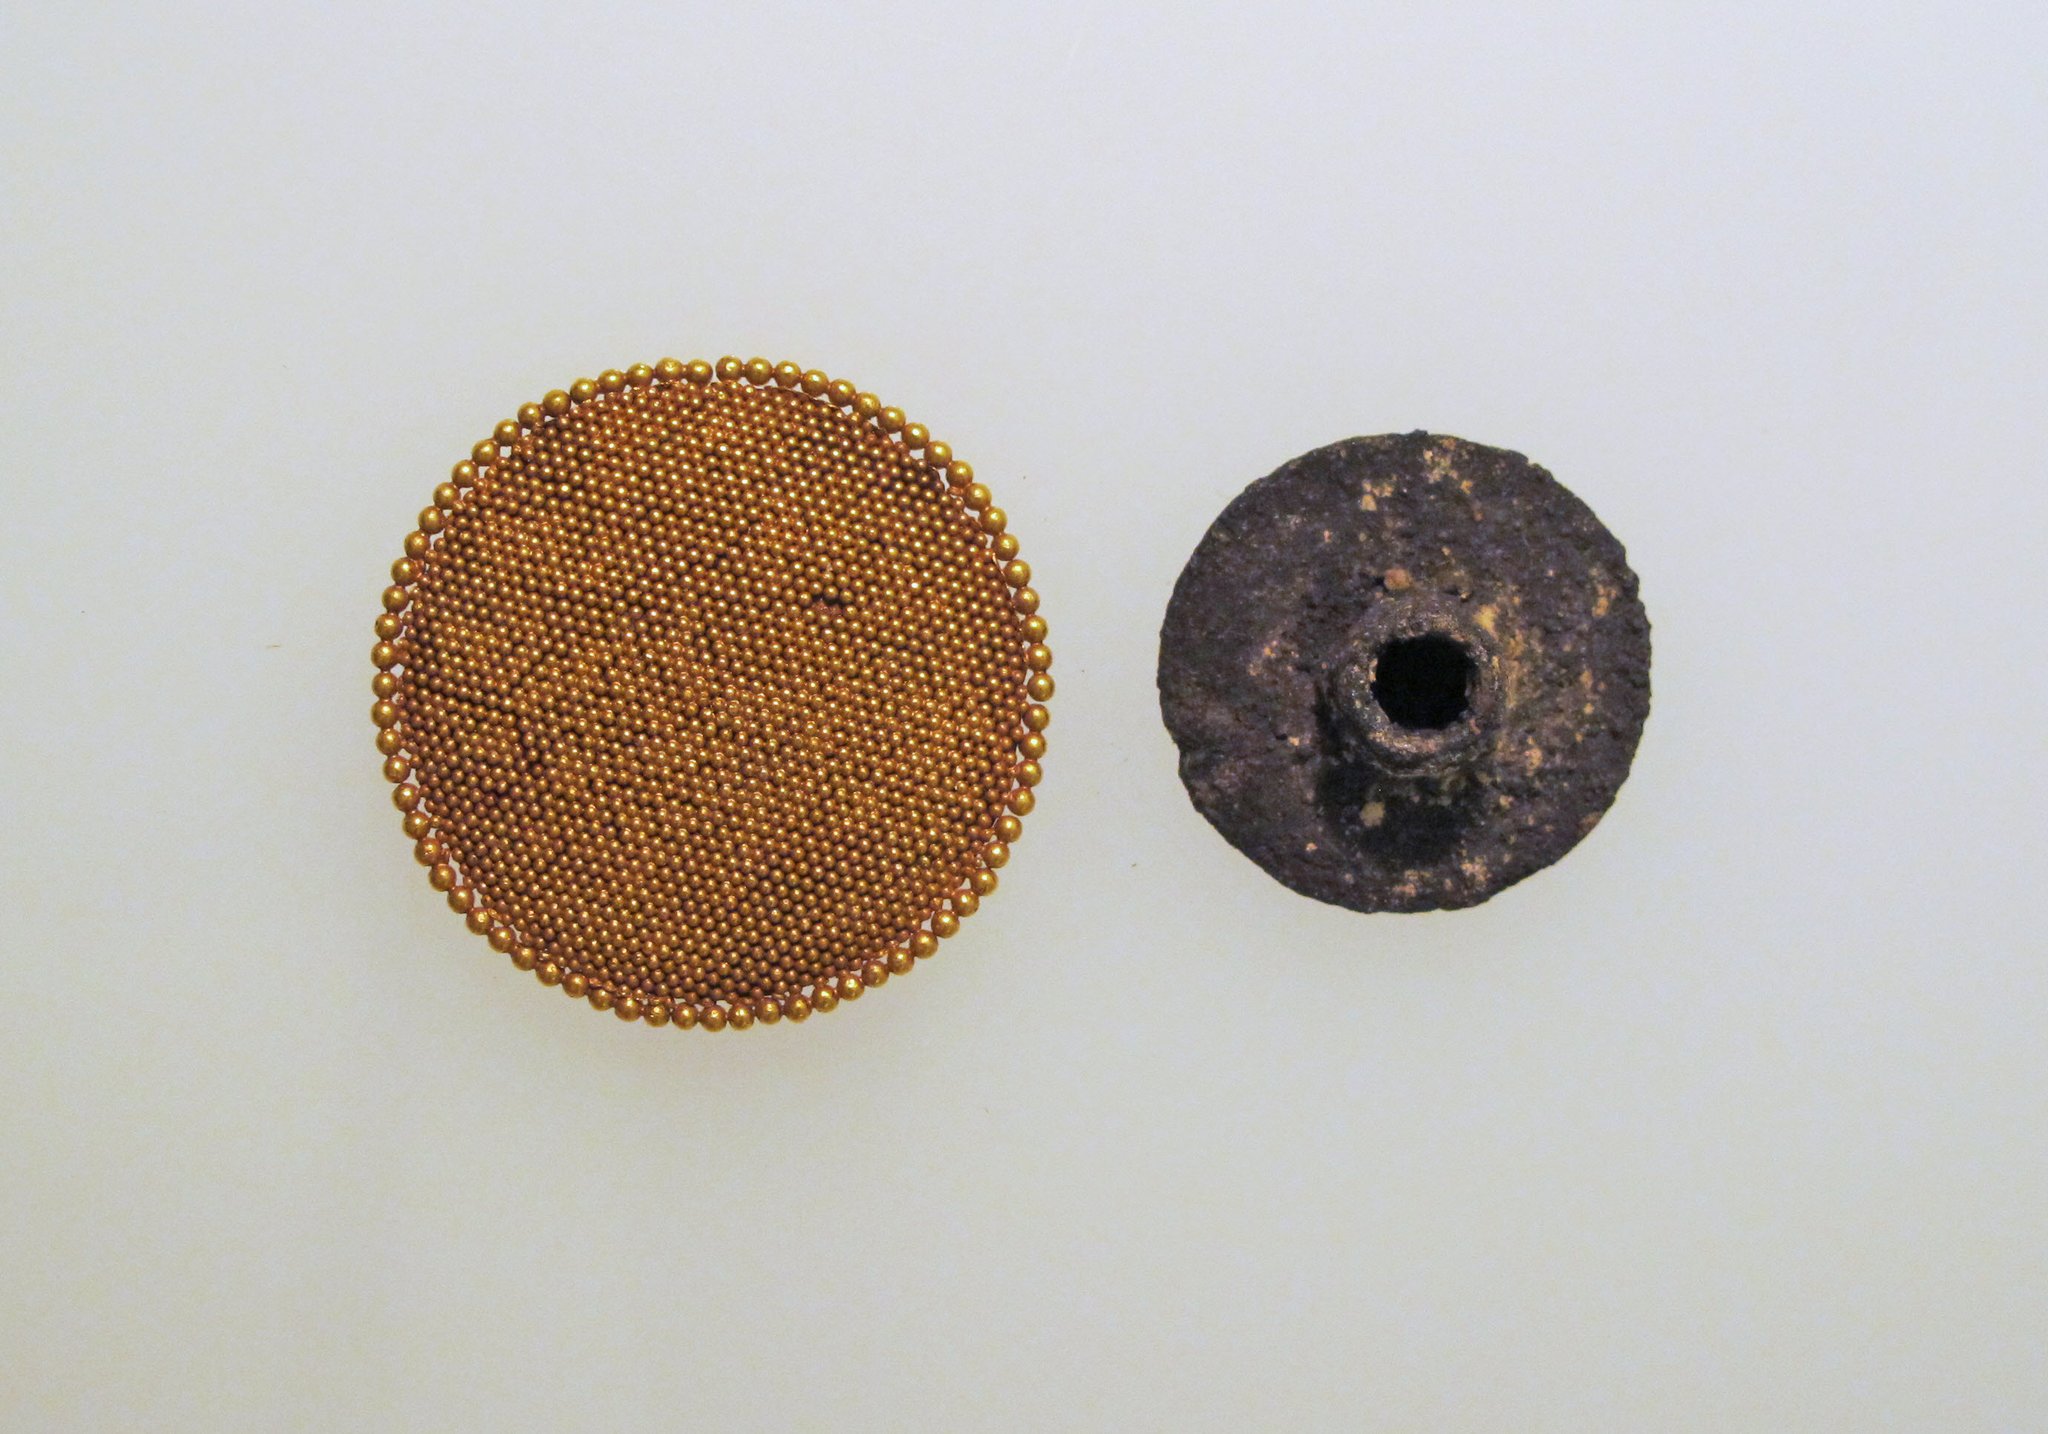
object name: ear stud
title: Earring stud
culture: cypriot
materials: silver